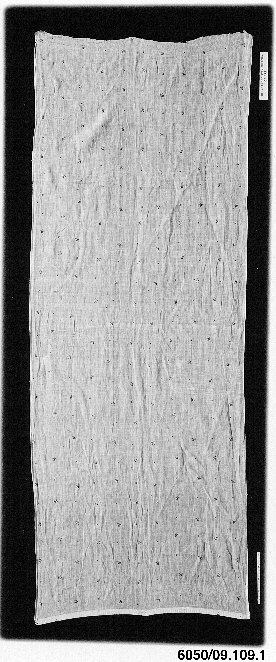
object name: textile fragment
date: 1701-1800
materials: cotton, metal thread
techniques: embroidery, weave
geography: india